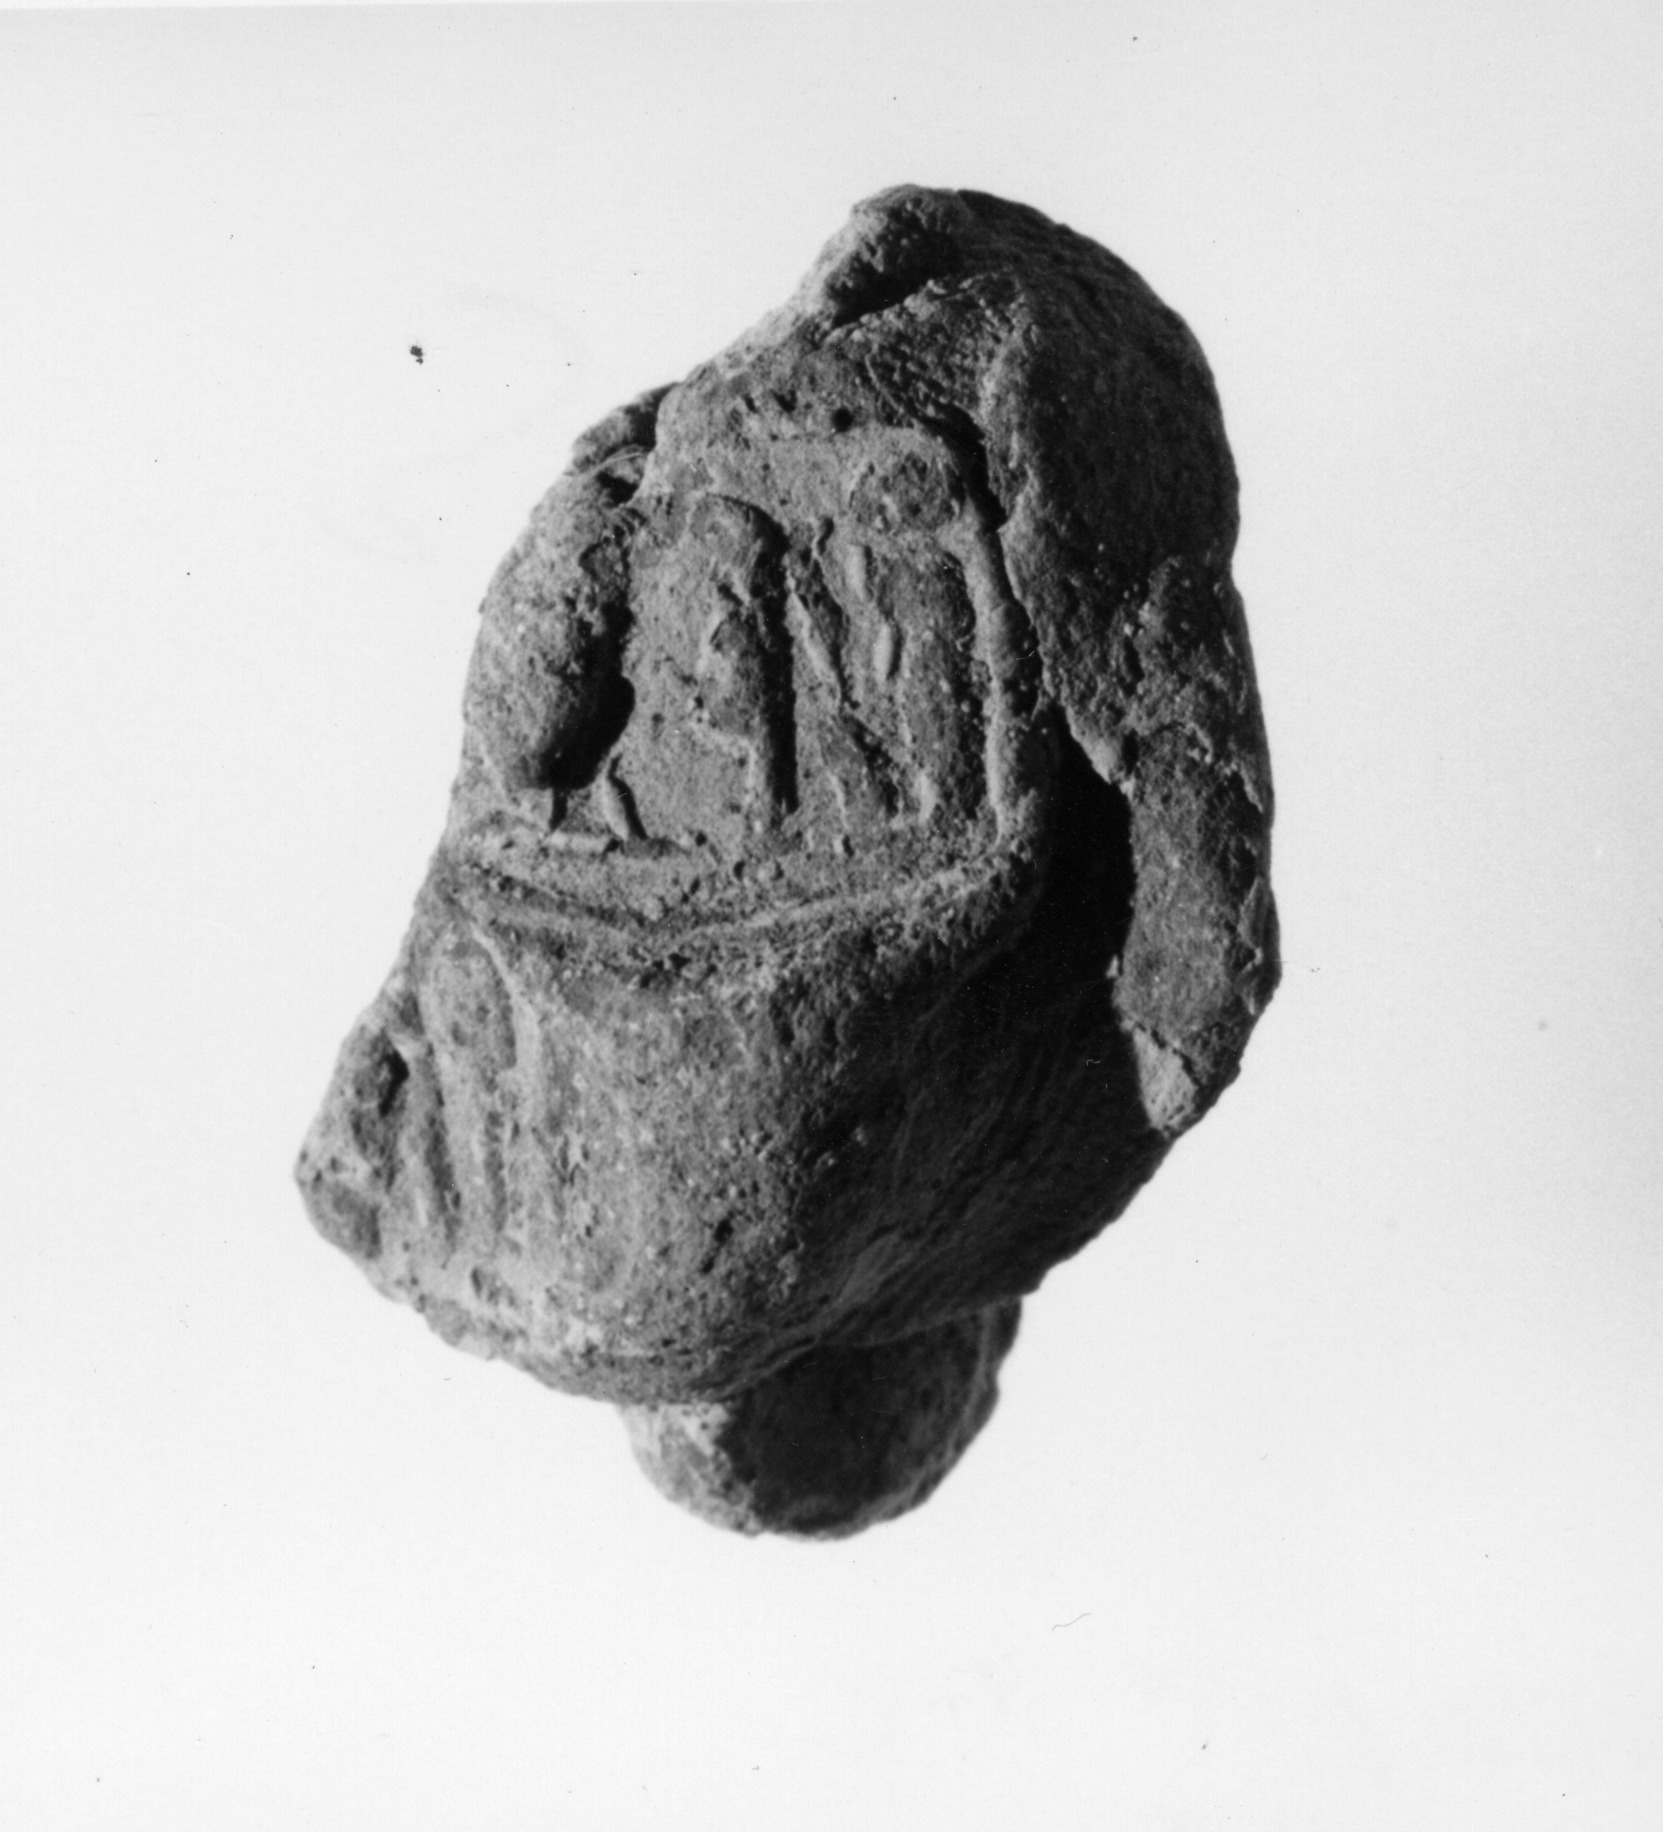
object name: sealing, amenhotep iii, nebmaatre, horus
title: Document Sealing With Multiple Seal Impressions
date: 1390-1352 BCE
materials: mud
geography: egypt